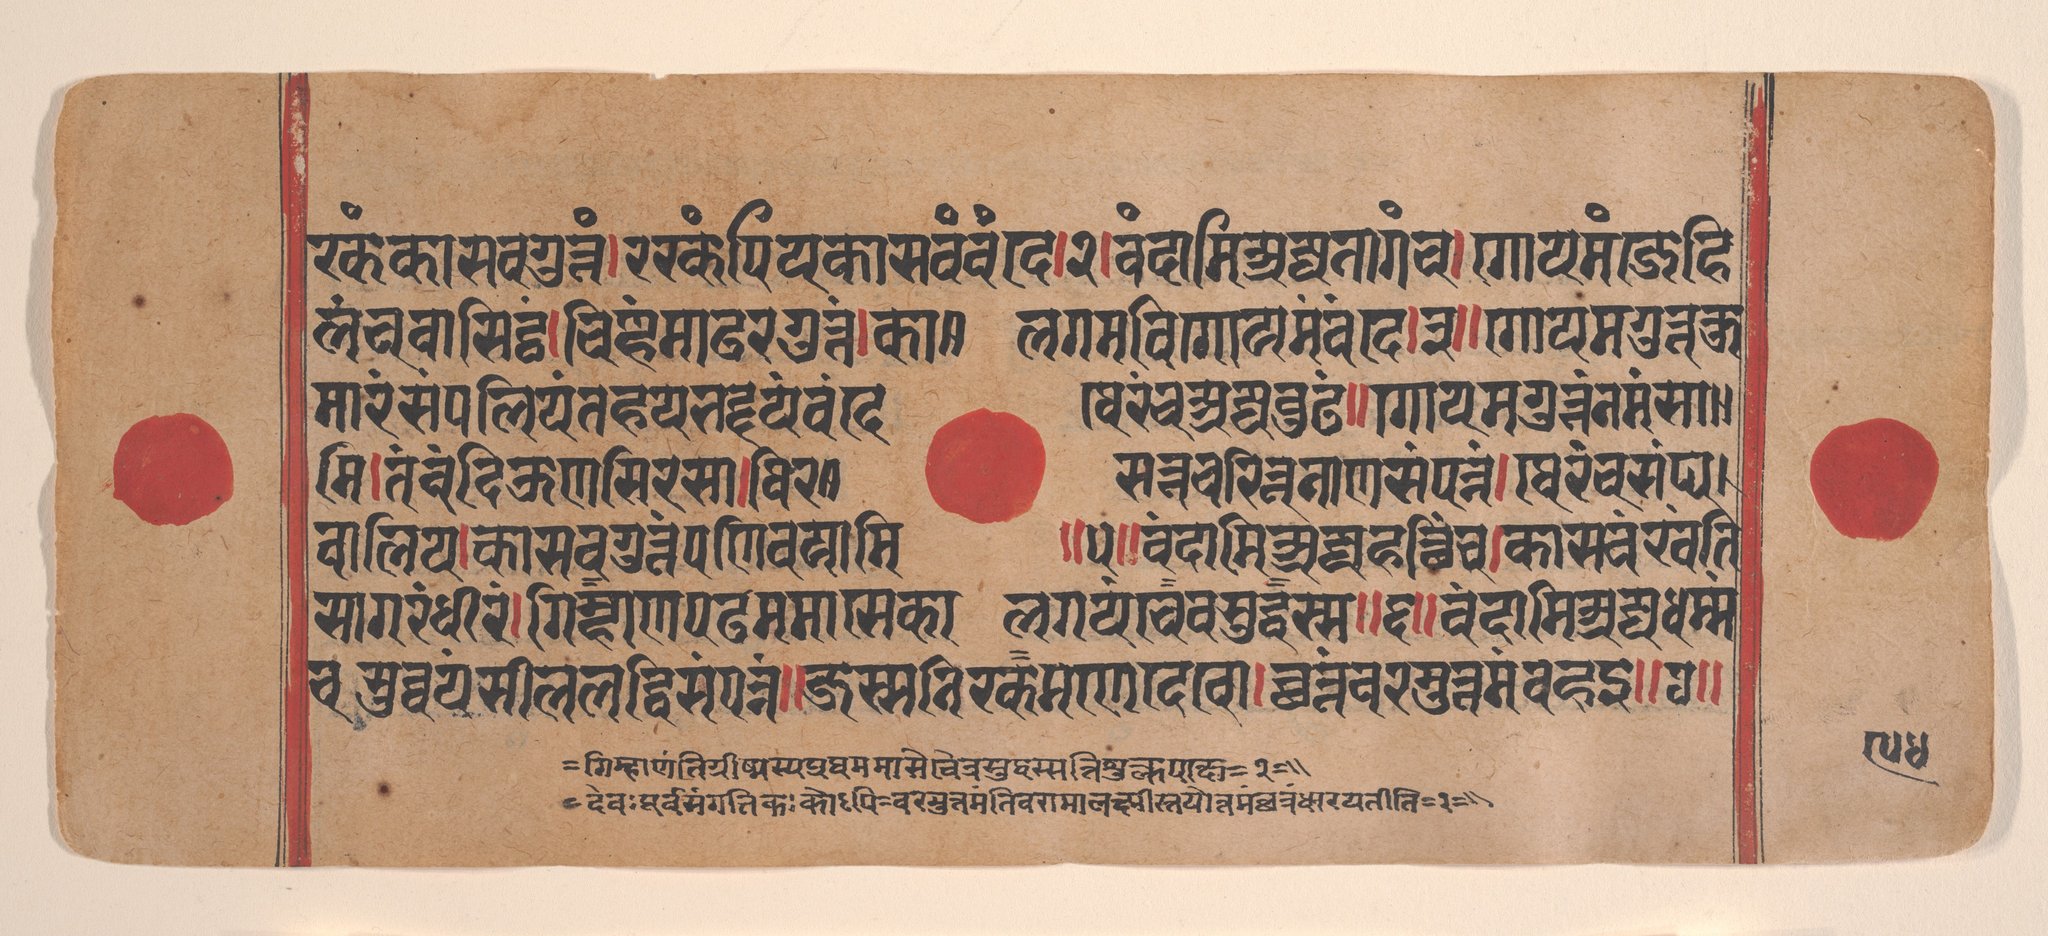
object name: folio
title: Page from a Dispersed Kalpa Sutra (Jain Book of Rituals)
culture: indian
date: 1401-1500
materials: gold, ink, paper, watercolor